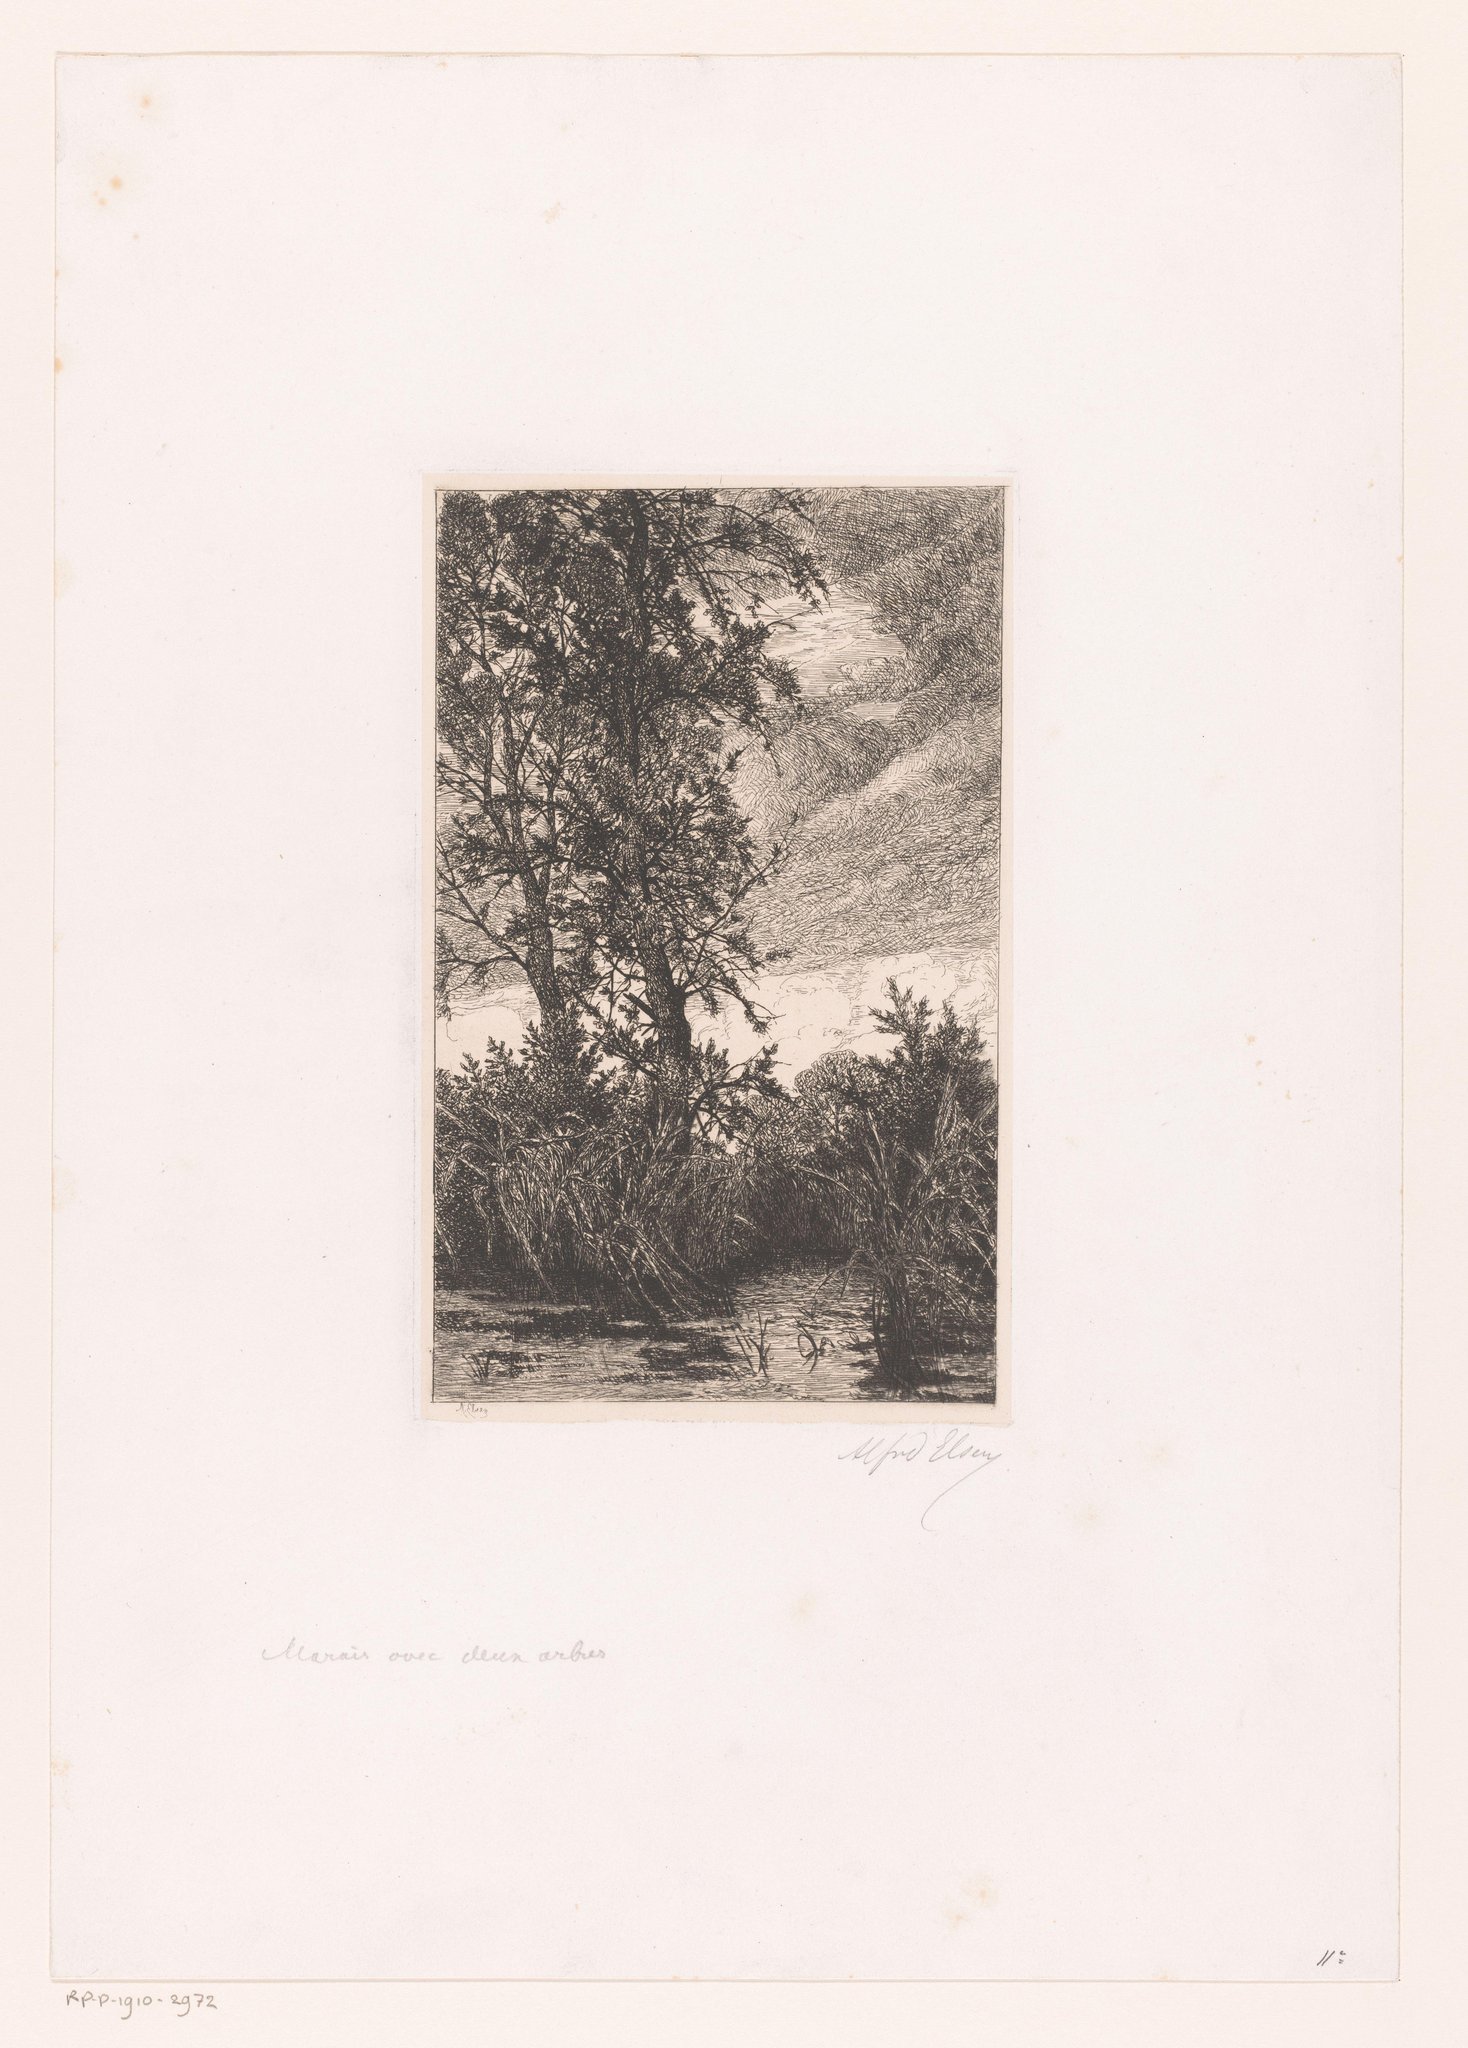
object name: print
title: Twee bomen aan het water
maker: alfred elsen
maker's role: painter, print maker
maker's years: 1850-1914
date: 1860-1910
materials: paper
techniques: etching, intaglio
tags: trees, landscapes with waters, waterscapes, seascapes (in the temperate zone)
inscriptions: collector's mark: Lugt 2228